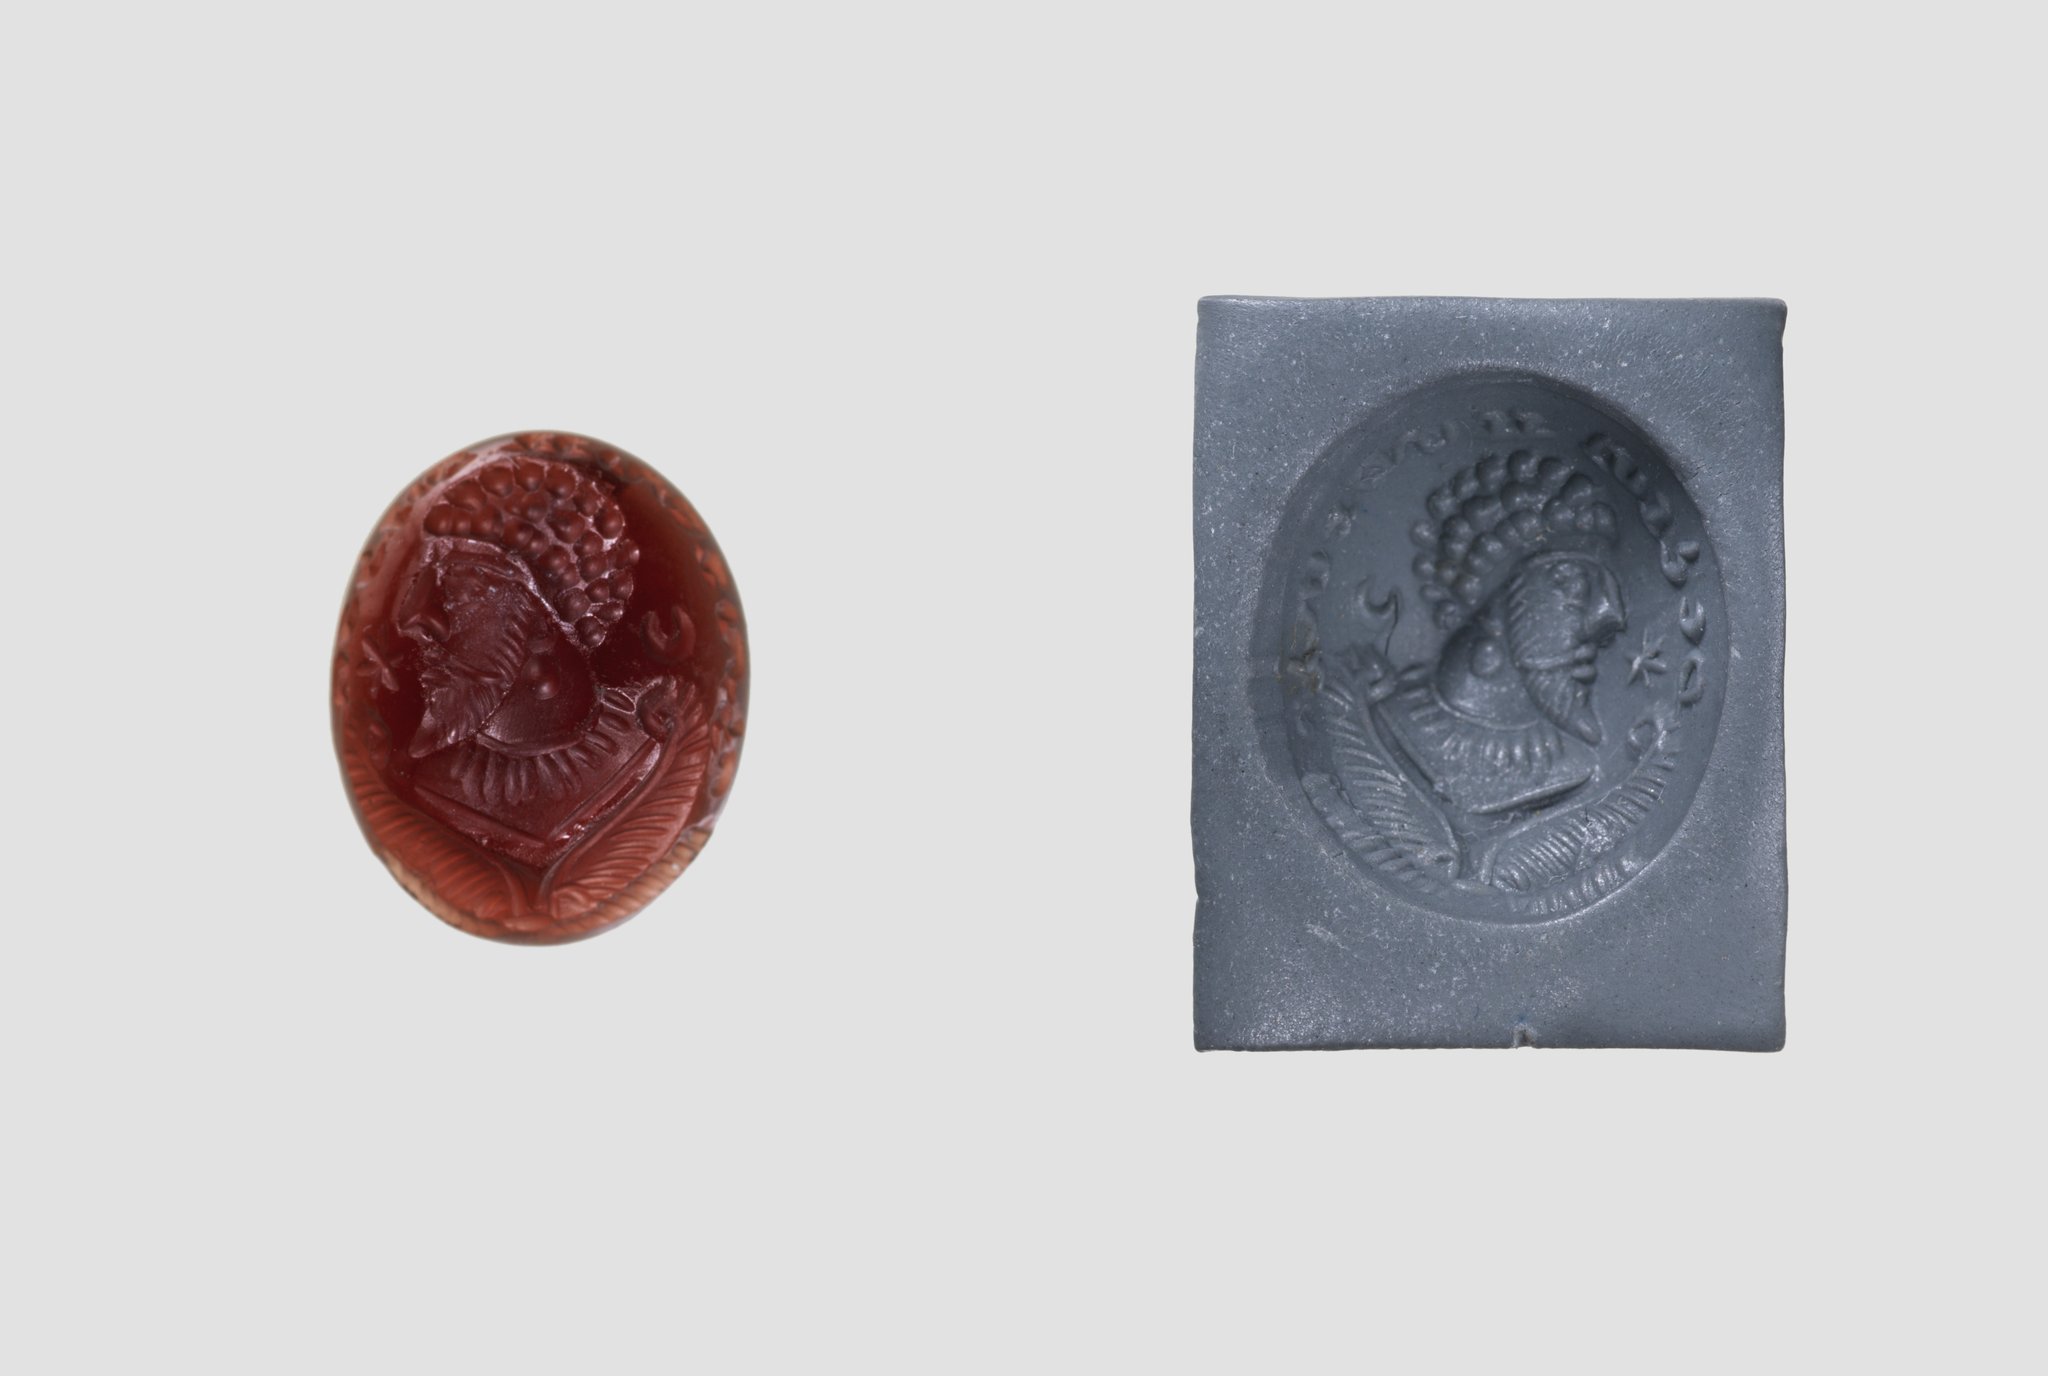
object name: stamp seal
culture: sasanian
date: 334-366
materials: gemstone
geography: iran or mesopotamia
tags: men